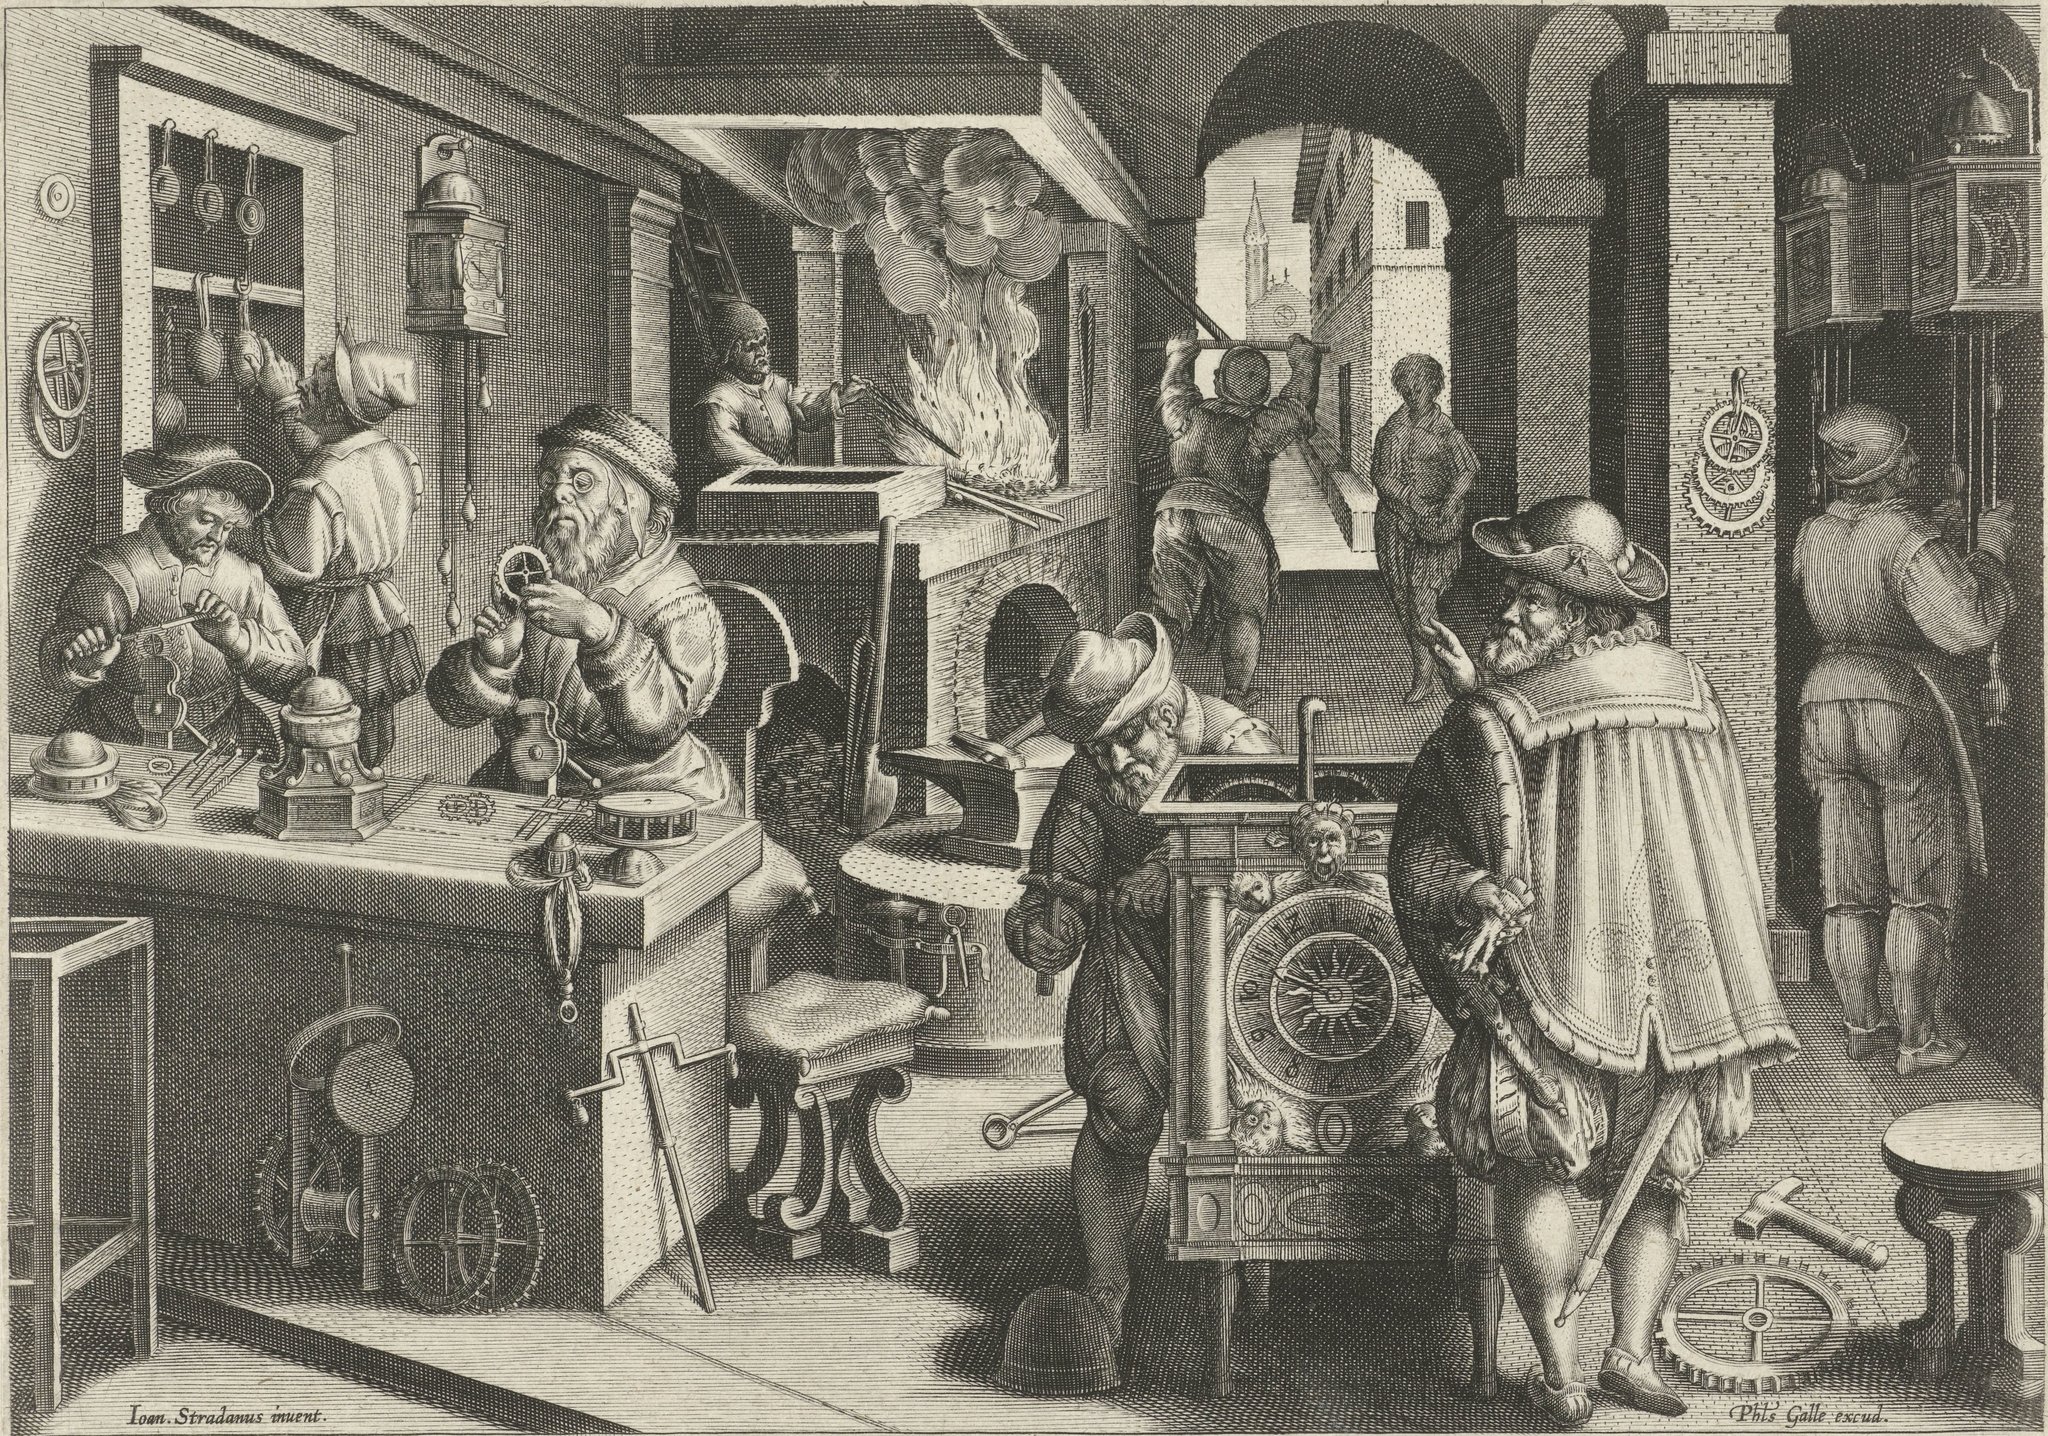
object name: print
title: Nieuwe uitvindingen en ontdekkingen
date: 1589-1593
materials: paper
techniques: engraving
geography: antwerp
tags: invention, discovery ~ science and technology, workshop (+ men (labourers)), watchmaker, clockmaker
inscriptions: collector's mark: Lugt 2228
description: Werkplaats waar uurwerken worden vervaardigd. Links twee klokkenmakers bezig aan een werkbank met het raderwerk. Middenvoor een klok met wijzerplaat. Op de achtergrond links wordt een oven gestookt; rechts hangen klokken aan de wand. De prent maakt deel uit van een negentiendelige serie over nieuwe uitvindingen en ontdekkingen. Afgeknipt exemplaar.